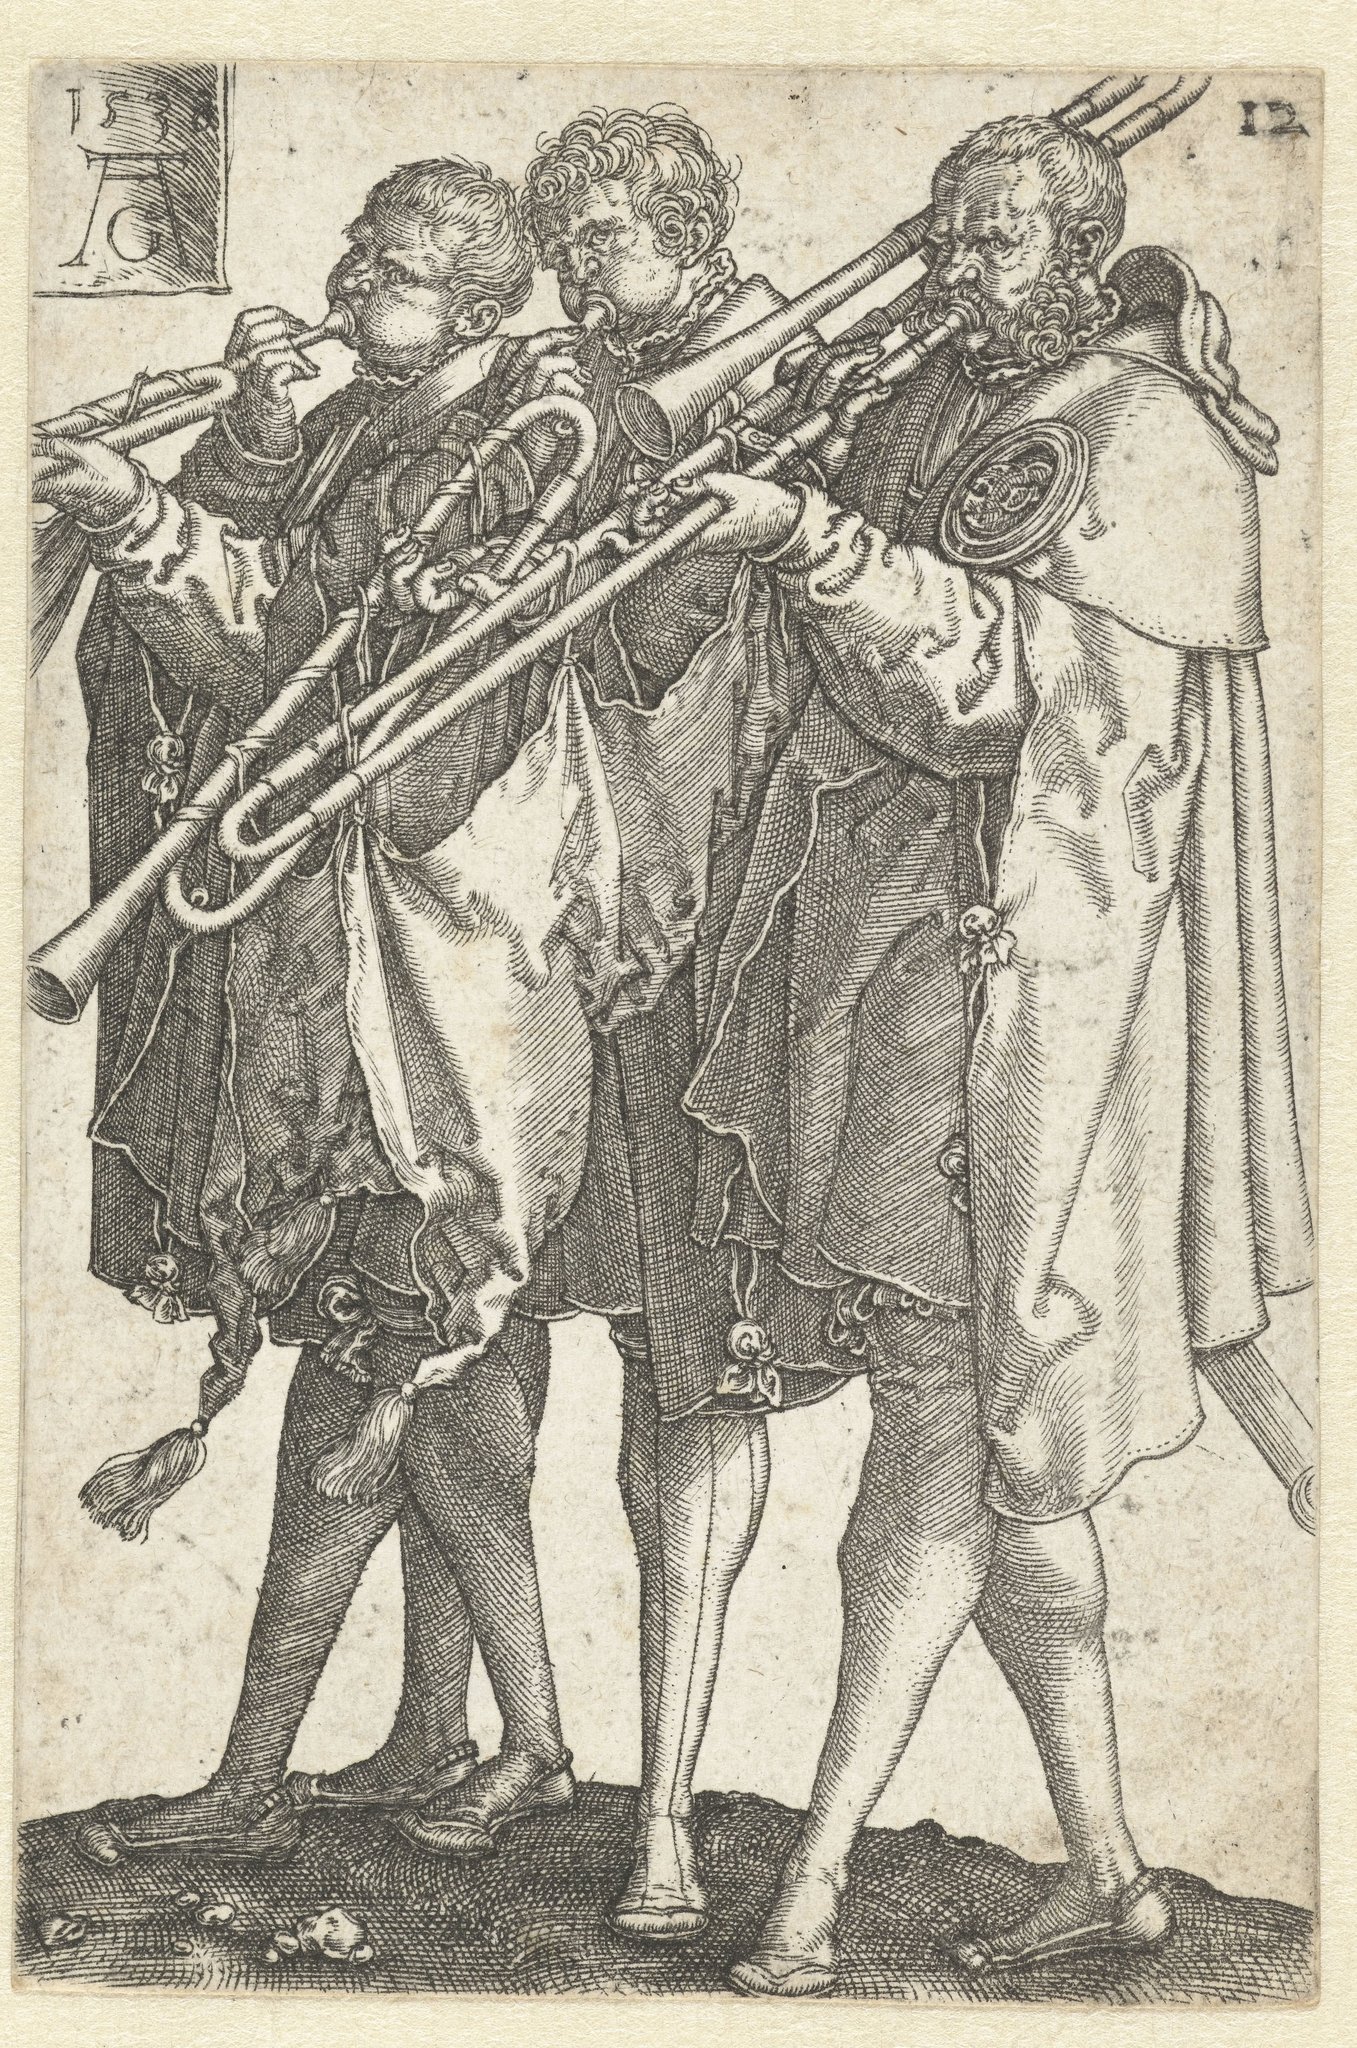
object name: print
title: Drie muzikanten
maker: heinrich aldegrever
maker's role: draughtsman, print maker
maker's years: 1502-1561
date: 1538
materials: paper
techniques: engraving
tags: horn, trumpet, cornet, trombone, tuba, more than one musician with instrument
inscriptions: collector's mark: ‘Hinloopen’ Lugt 11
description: Drie mannen spelend op een Sackbut (baroktrombone). Twaalfde prent uit een serie van twaalf, vrij naar het werk van Hans Schäufelein.